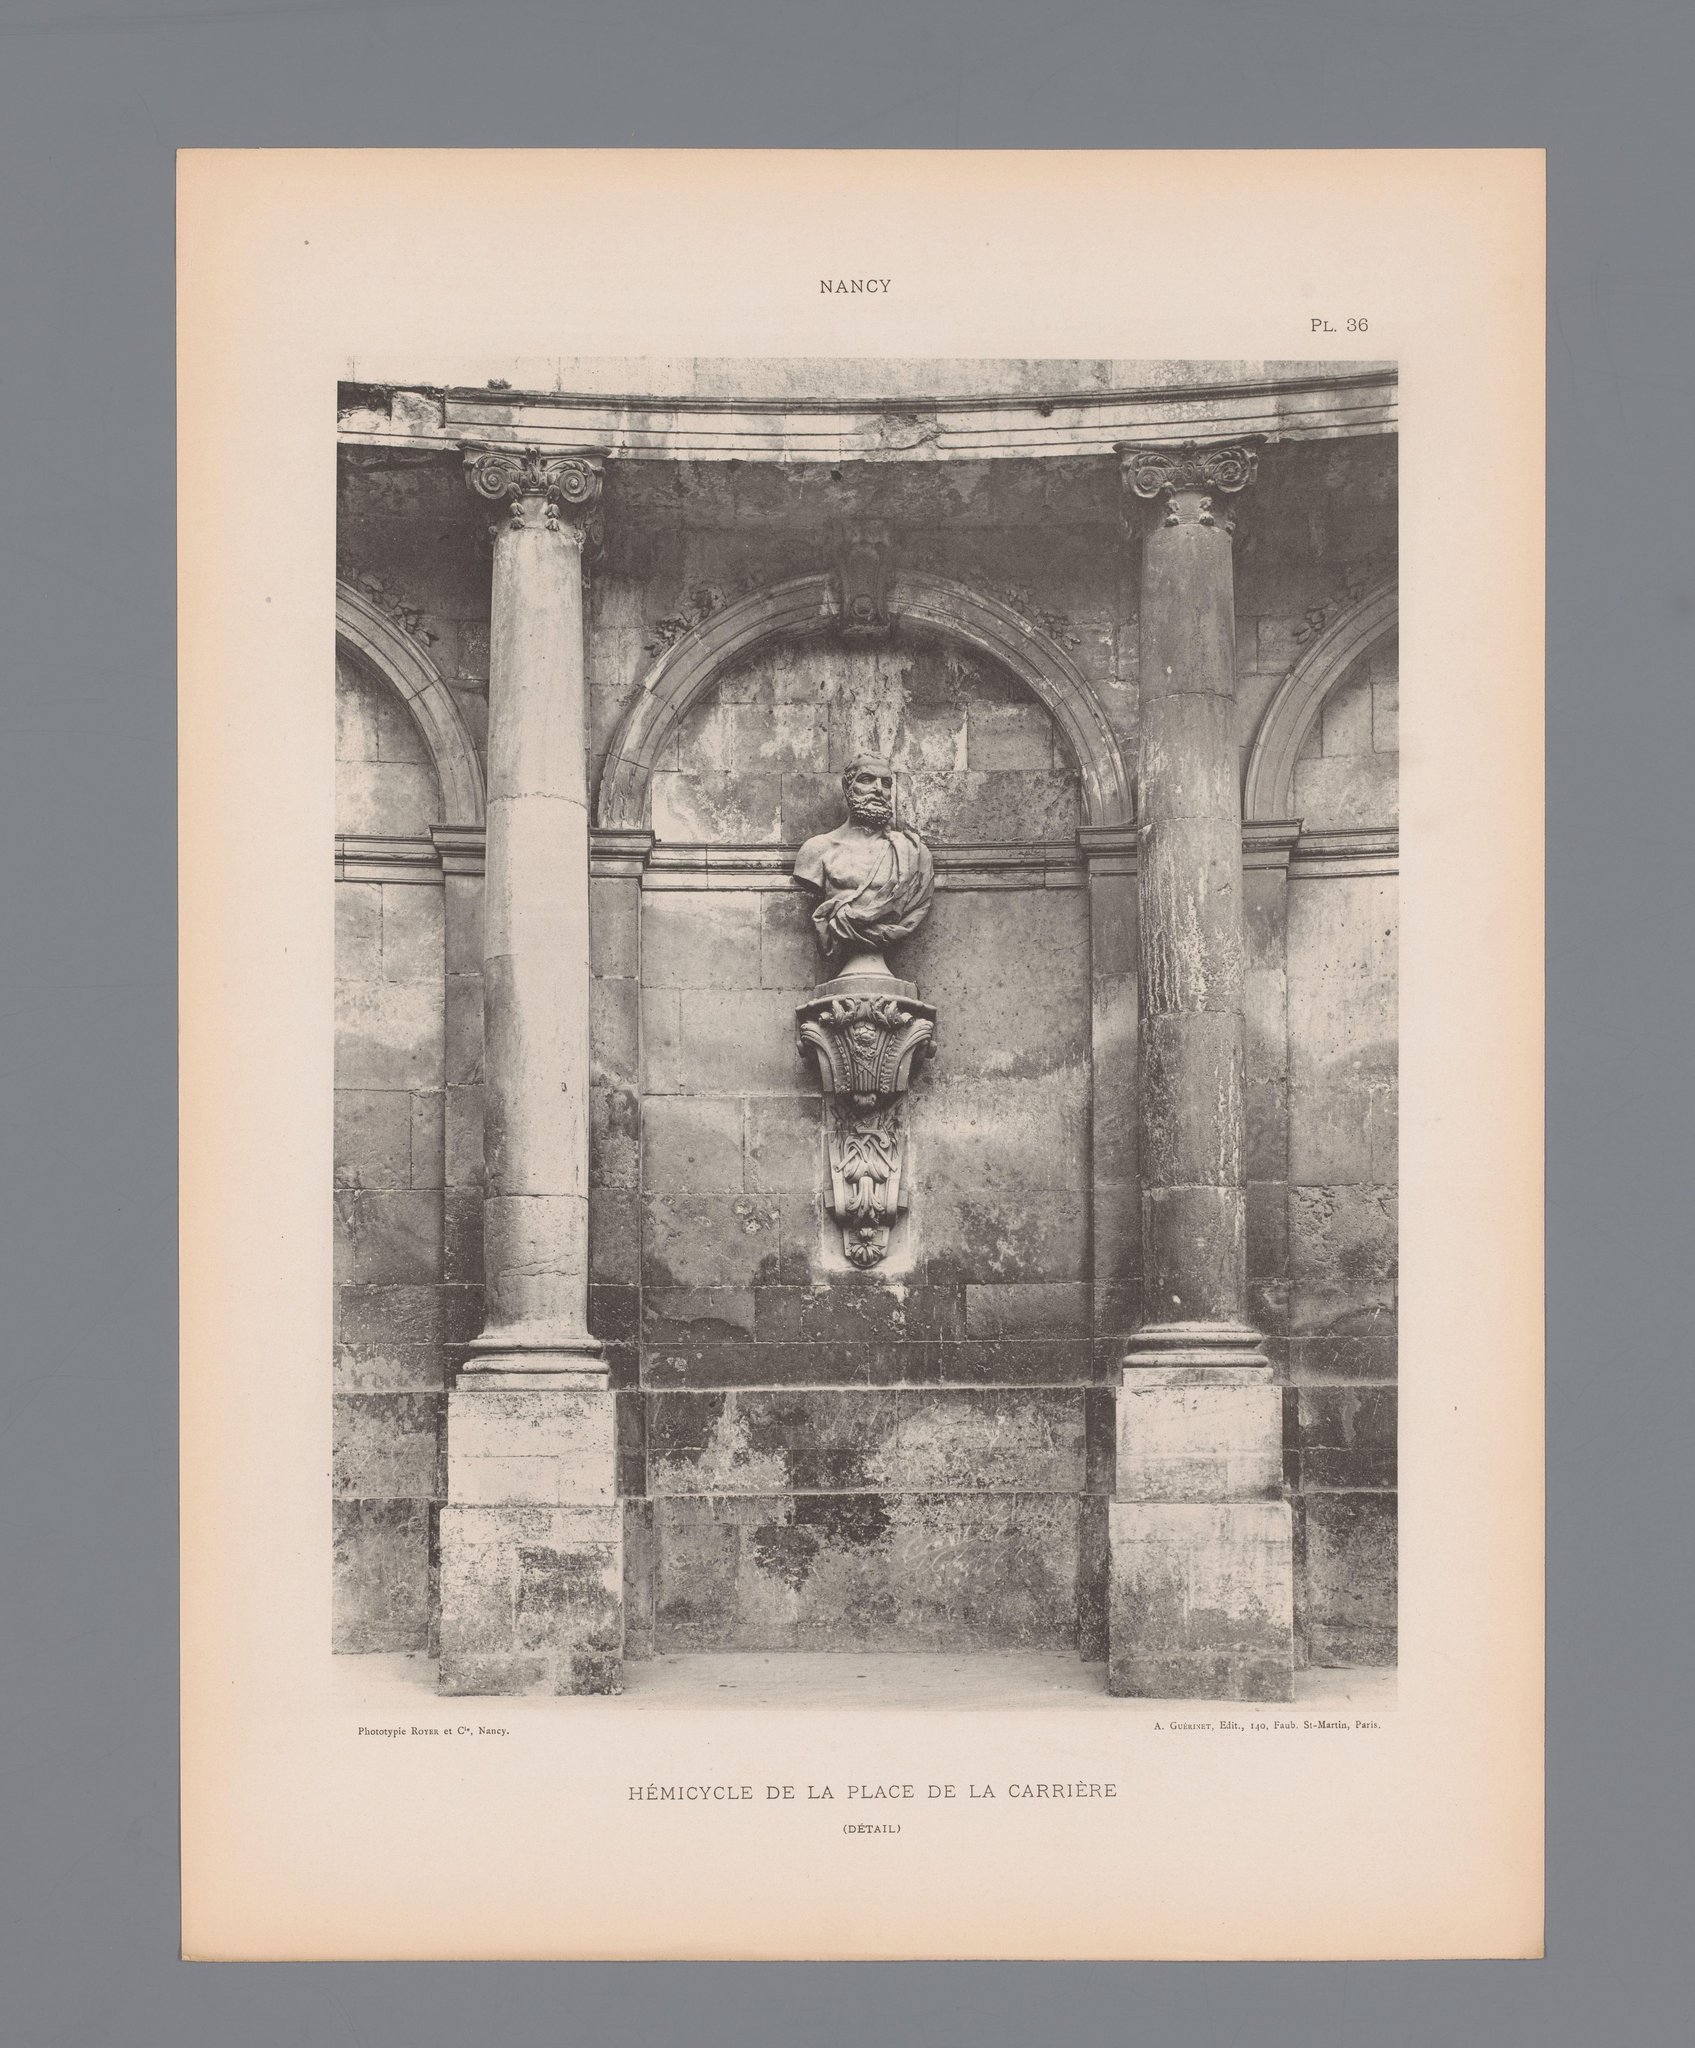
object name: photomechanical print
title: Buste in de colonnade op Place la Carrière te Nancy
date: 1891-1896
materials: paper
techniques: photograph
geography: nancy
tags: colonnade, column, pillar ~ architecture, piece of sculpture, reproduction of a piece of sculpture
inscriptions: inscription: ‘Hémicycle de la Place de la Carrière (...)’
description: Deze prent maakt deel uit van een omslag met 103 prenten op 101 bladen en een titelblad.